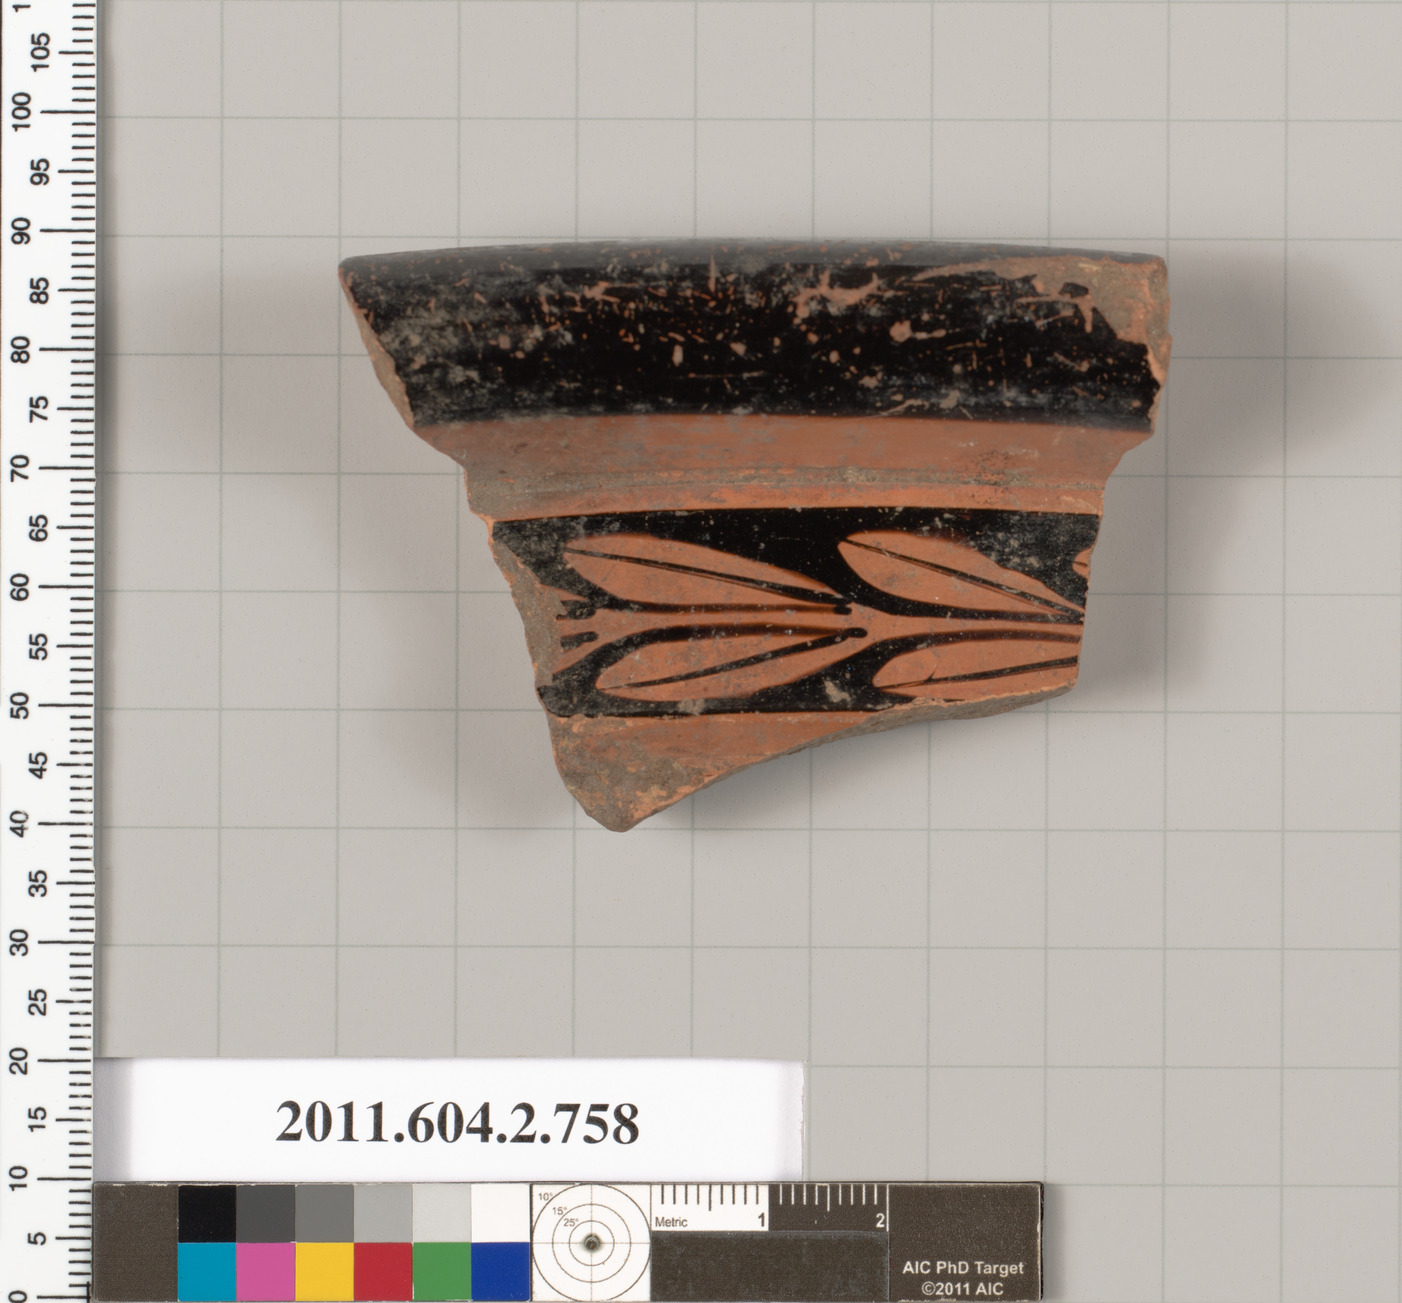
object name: calyx krater fragment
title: Terracotta fragment of a calyx-krater (bowl for mixing wine and water)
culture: greek, attic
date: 460-450 BCE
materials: terracotta